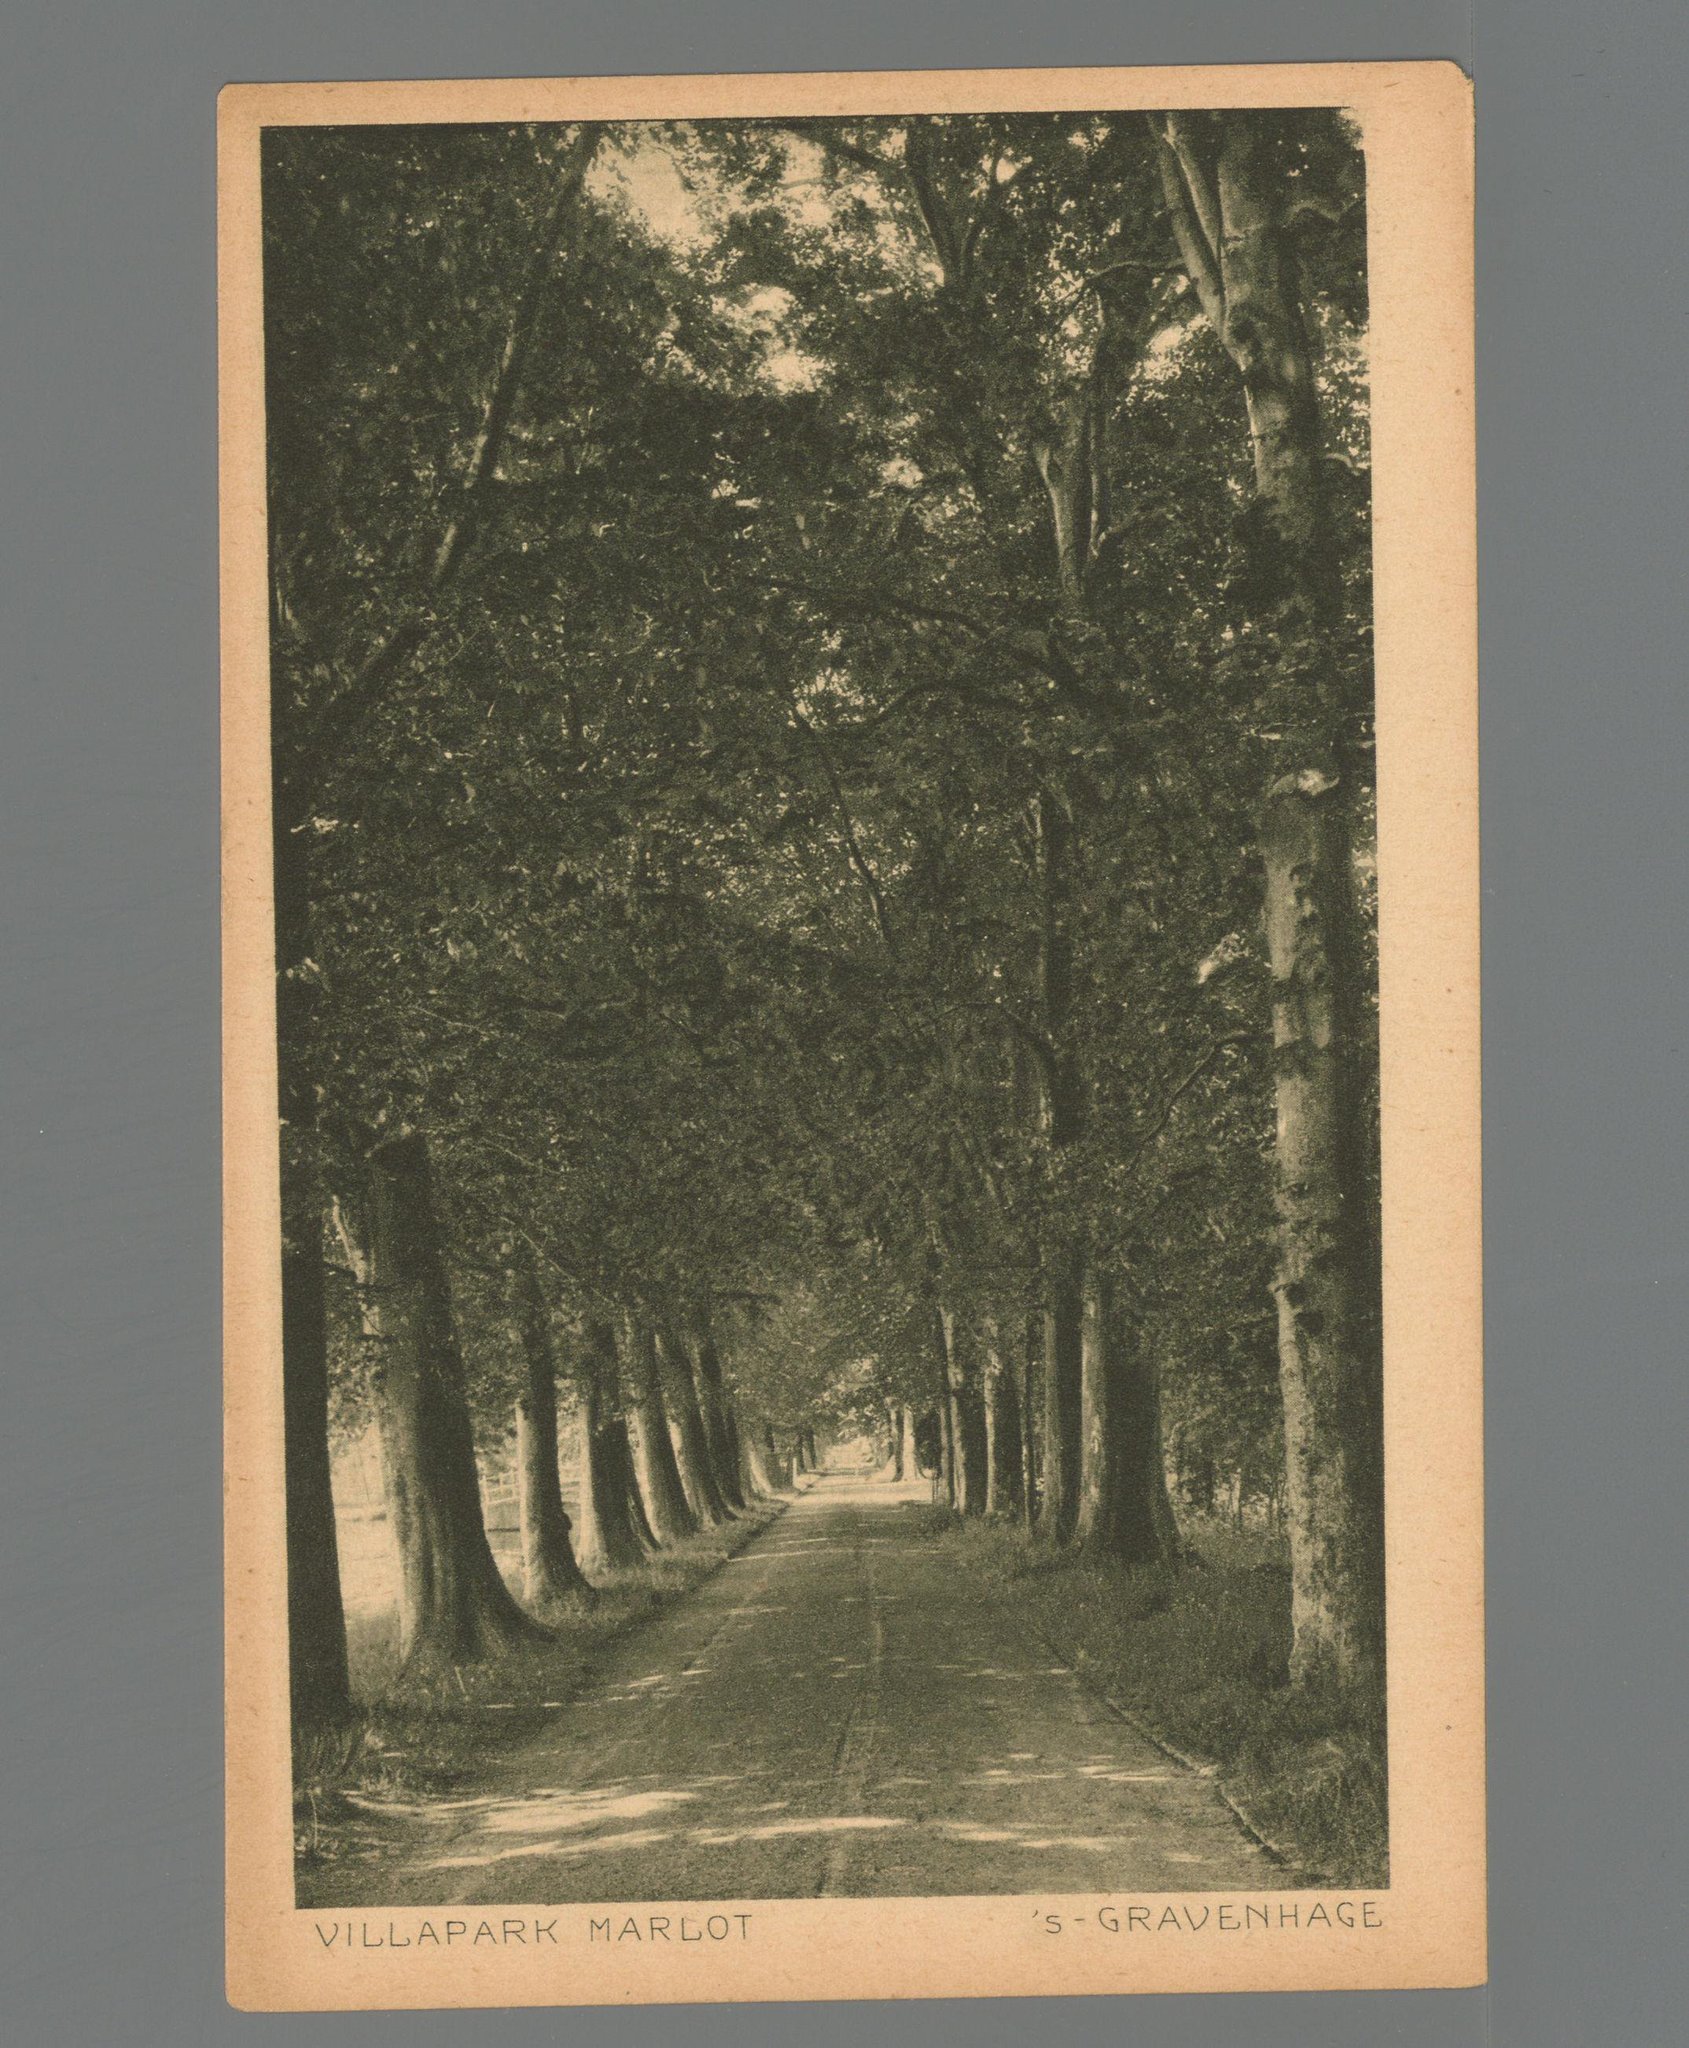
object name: ansichtkaart, prentbriefkaart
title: Villapark Marlot. 's-Gravenhage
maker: johannes gerardus happel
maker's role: publisher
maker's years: 1854-1928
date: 1913-1928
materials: cardboard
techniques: rotogravure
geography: the hague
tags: forest path or lane